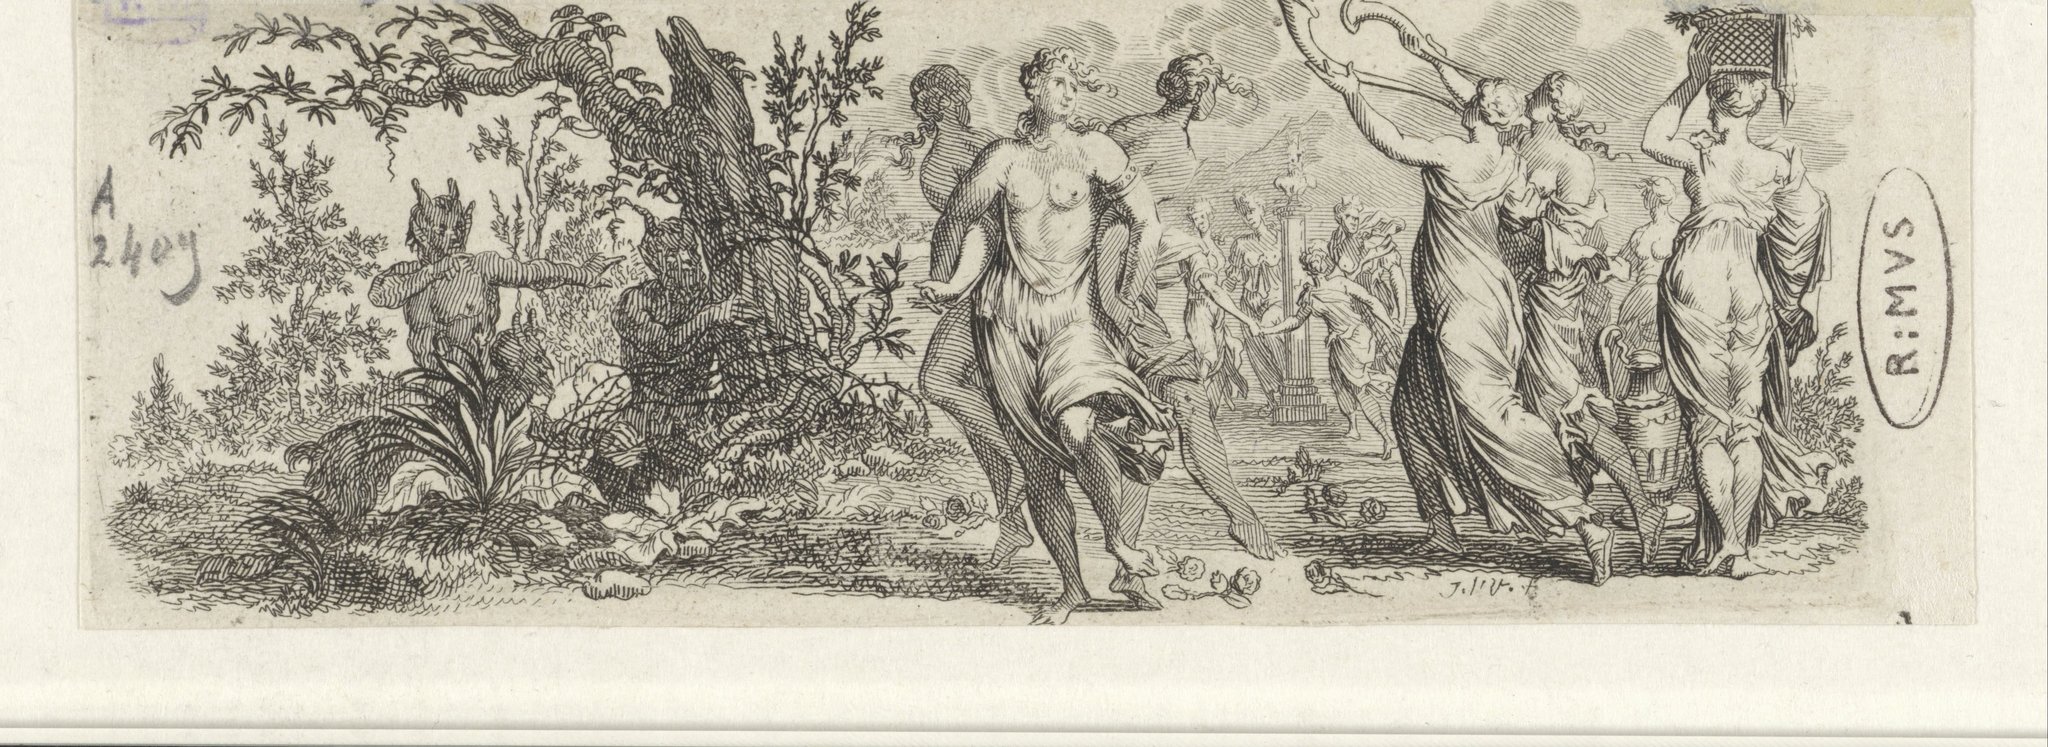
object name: book illustration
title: Dansende nimfen door saters bespied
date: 1701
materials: paper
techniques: engraving, etching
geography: amsterdam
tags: nymphs (in general); 'ninfe in commune' (ripa), satyr(s) spying upon, satyr(s) (in general)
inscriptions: collector's mark: Lugt 2228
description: Prent gebruikt als boekillustratie in: Phaedrus [bewerkt door D. Van Hoogstraten]. Fabularum Æsopiarum libri V. Amsterdam: François Halma, 1701.